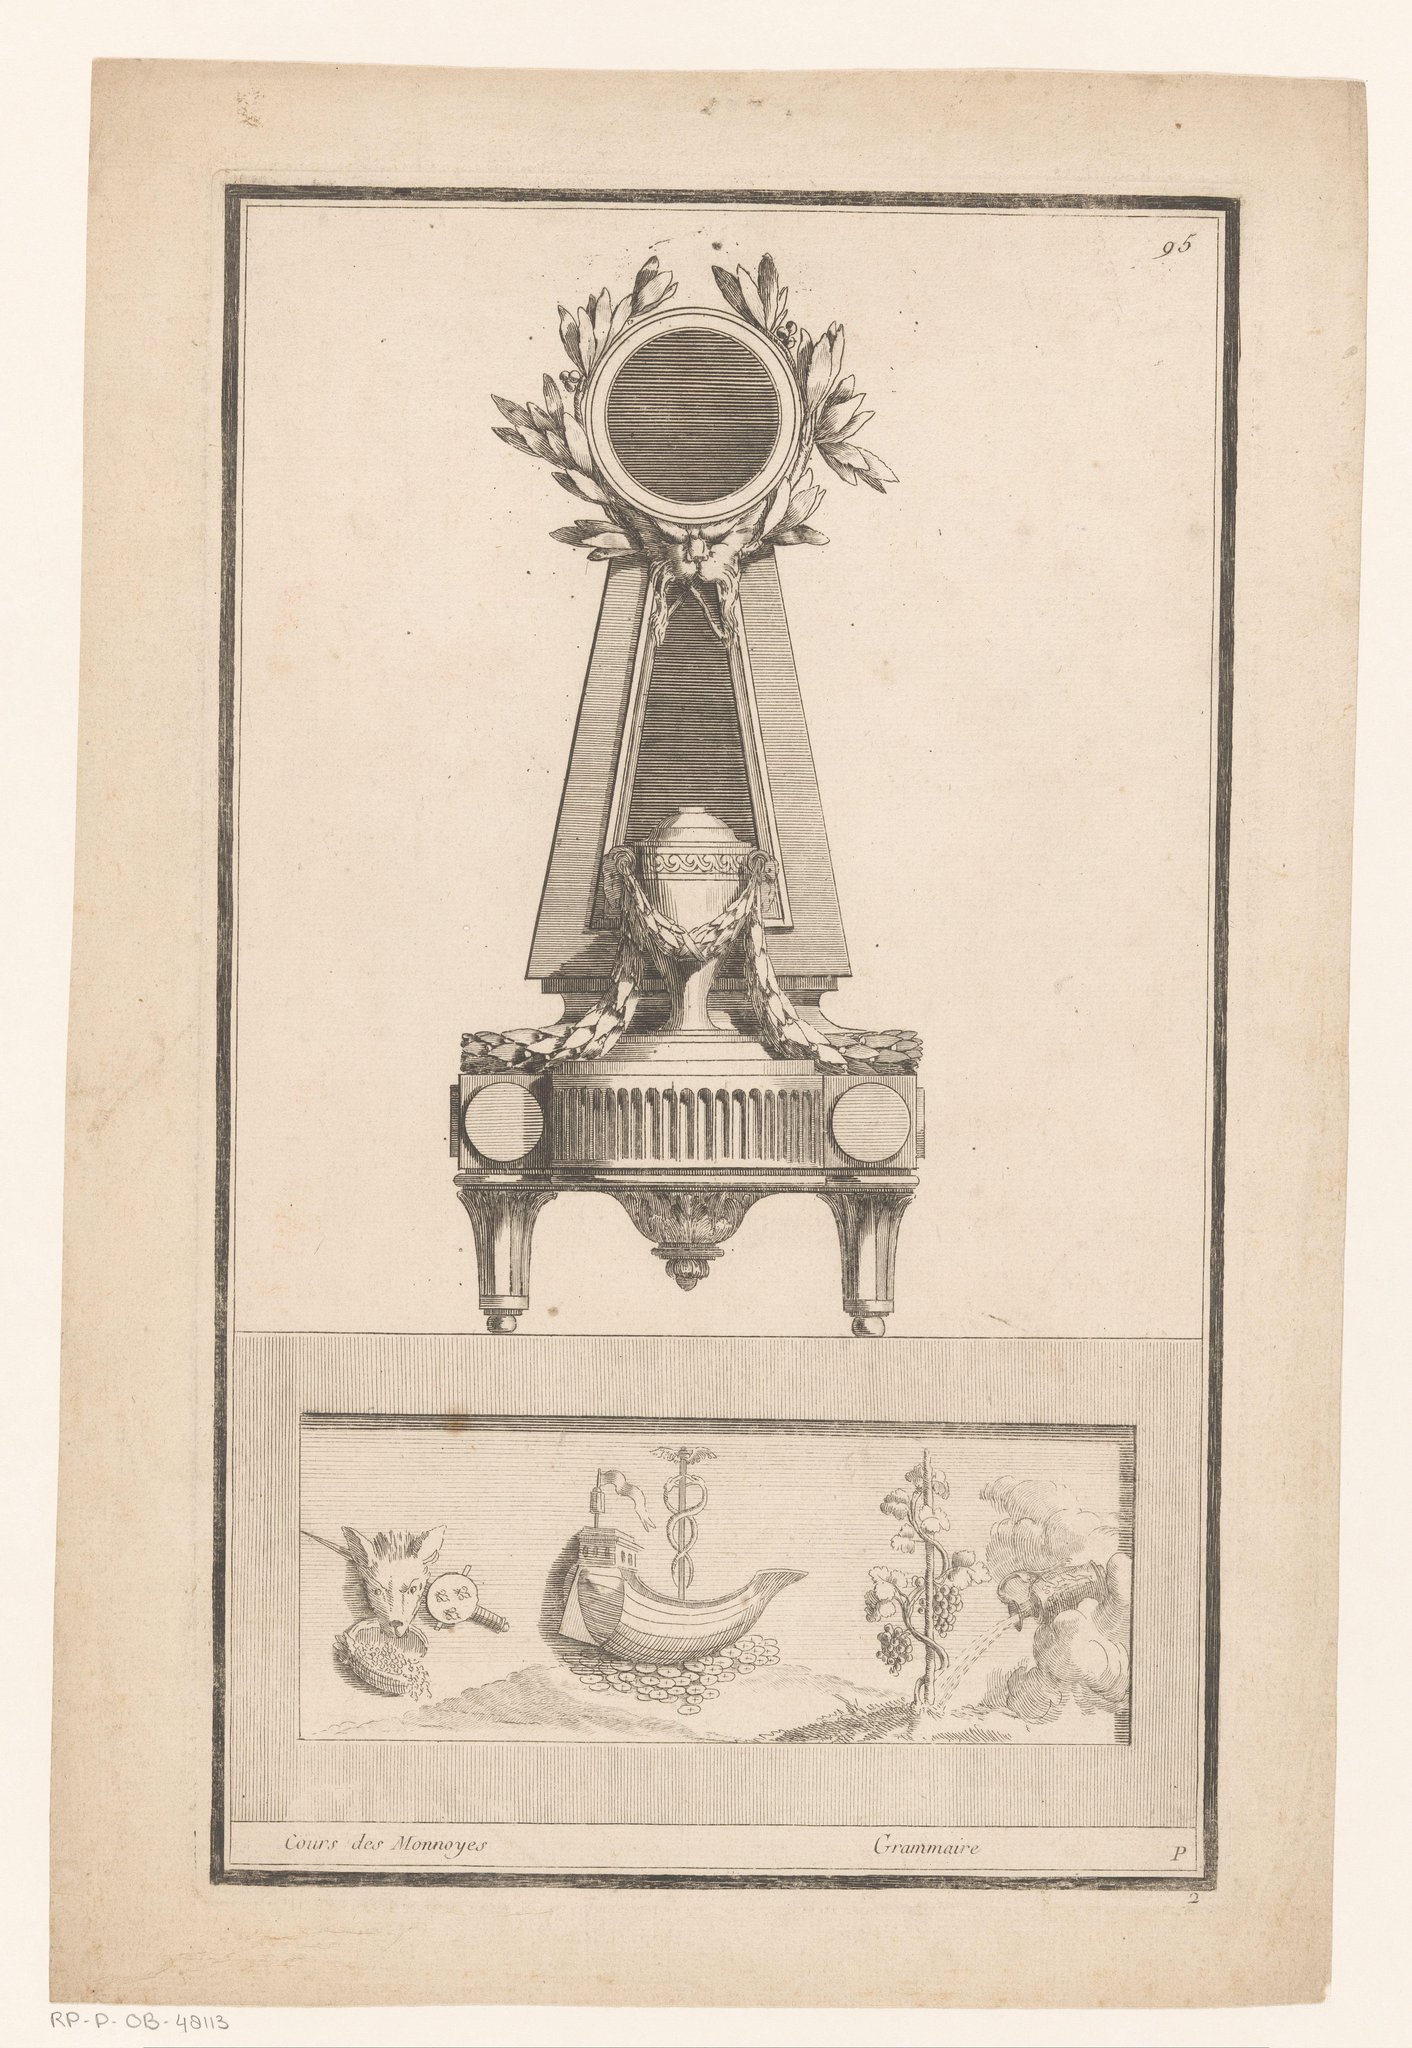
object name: print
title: Geldzaken en grammatica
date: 1768-1771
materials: paper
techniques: engraving, etching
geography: paris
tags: 'grammatica' (~ trivium); 'grammatica' (ripa), clock, money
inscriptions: collector's mark: Lugt 2228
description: Een geornamenteerde pendule met guirlandes, takken en een vaas. Daaronder een lijst met links een dierenkop met zwaard en granaatappel, in het midden een schip met een caduceus op munten en rechts stroomt water vanuit een vaas op druivenranken. Prentnummer 95.